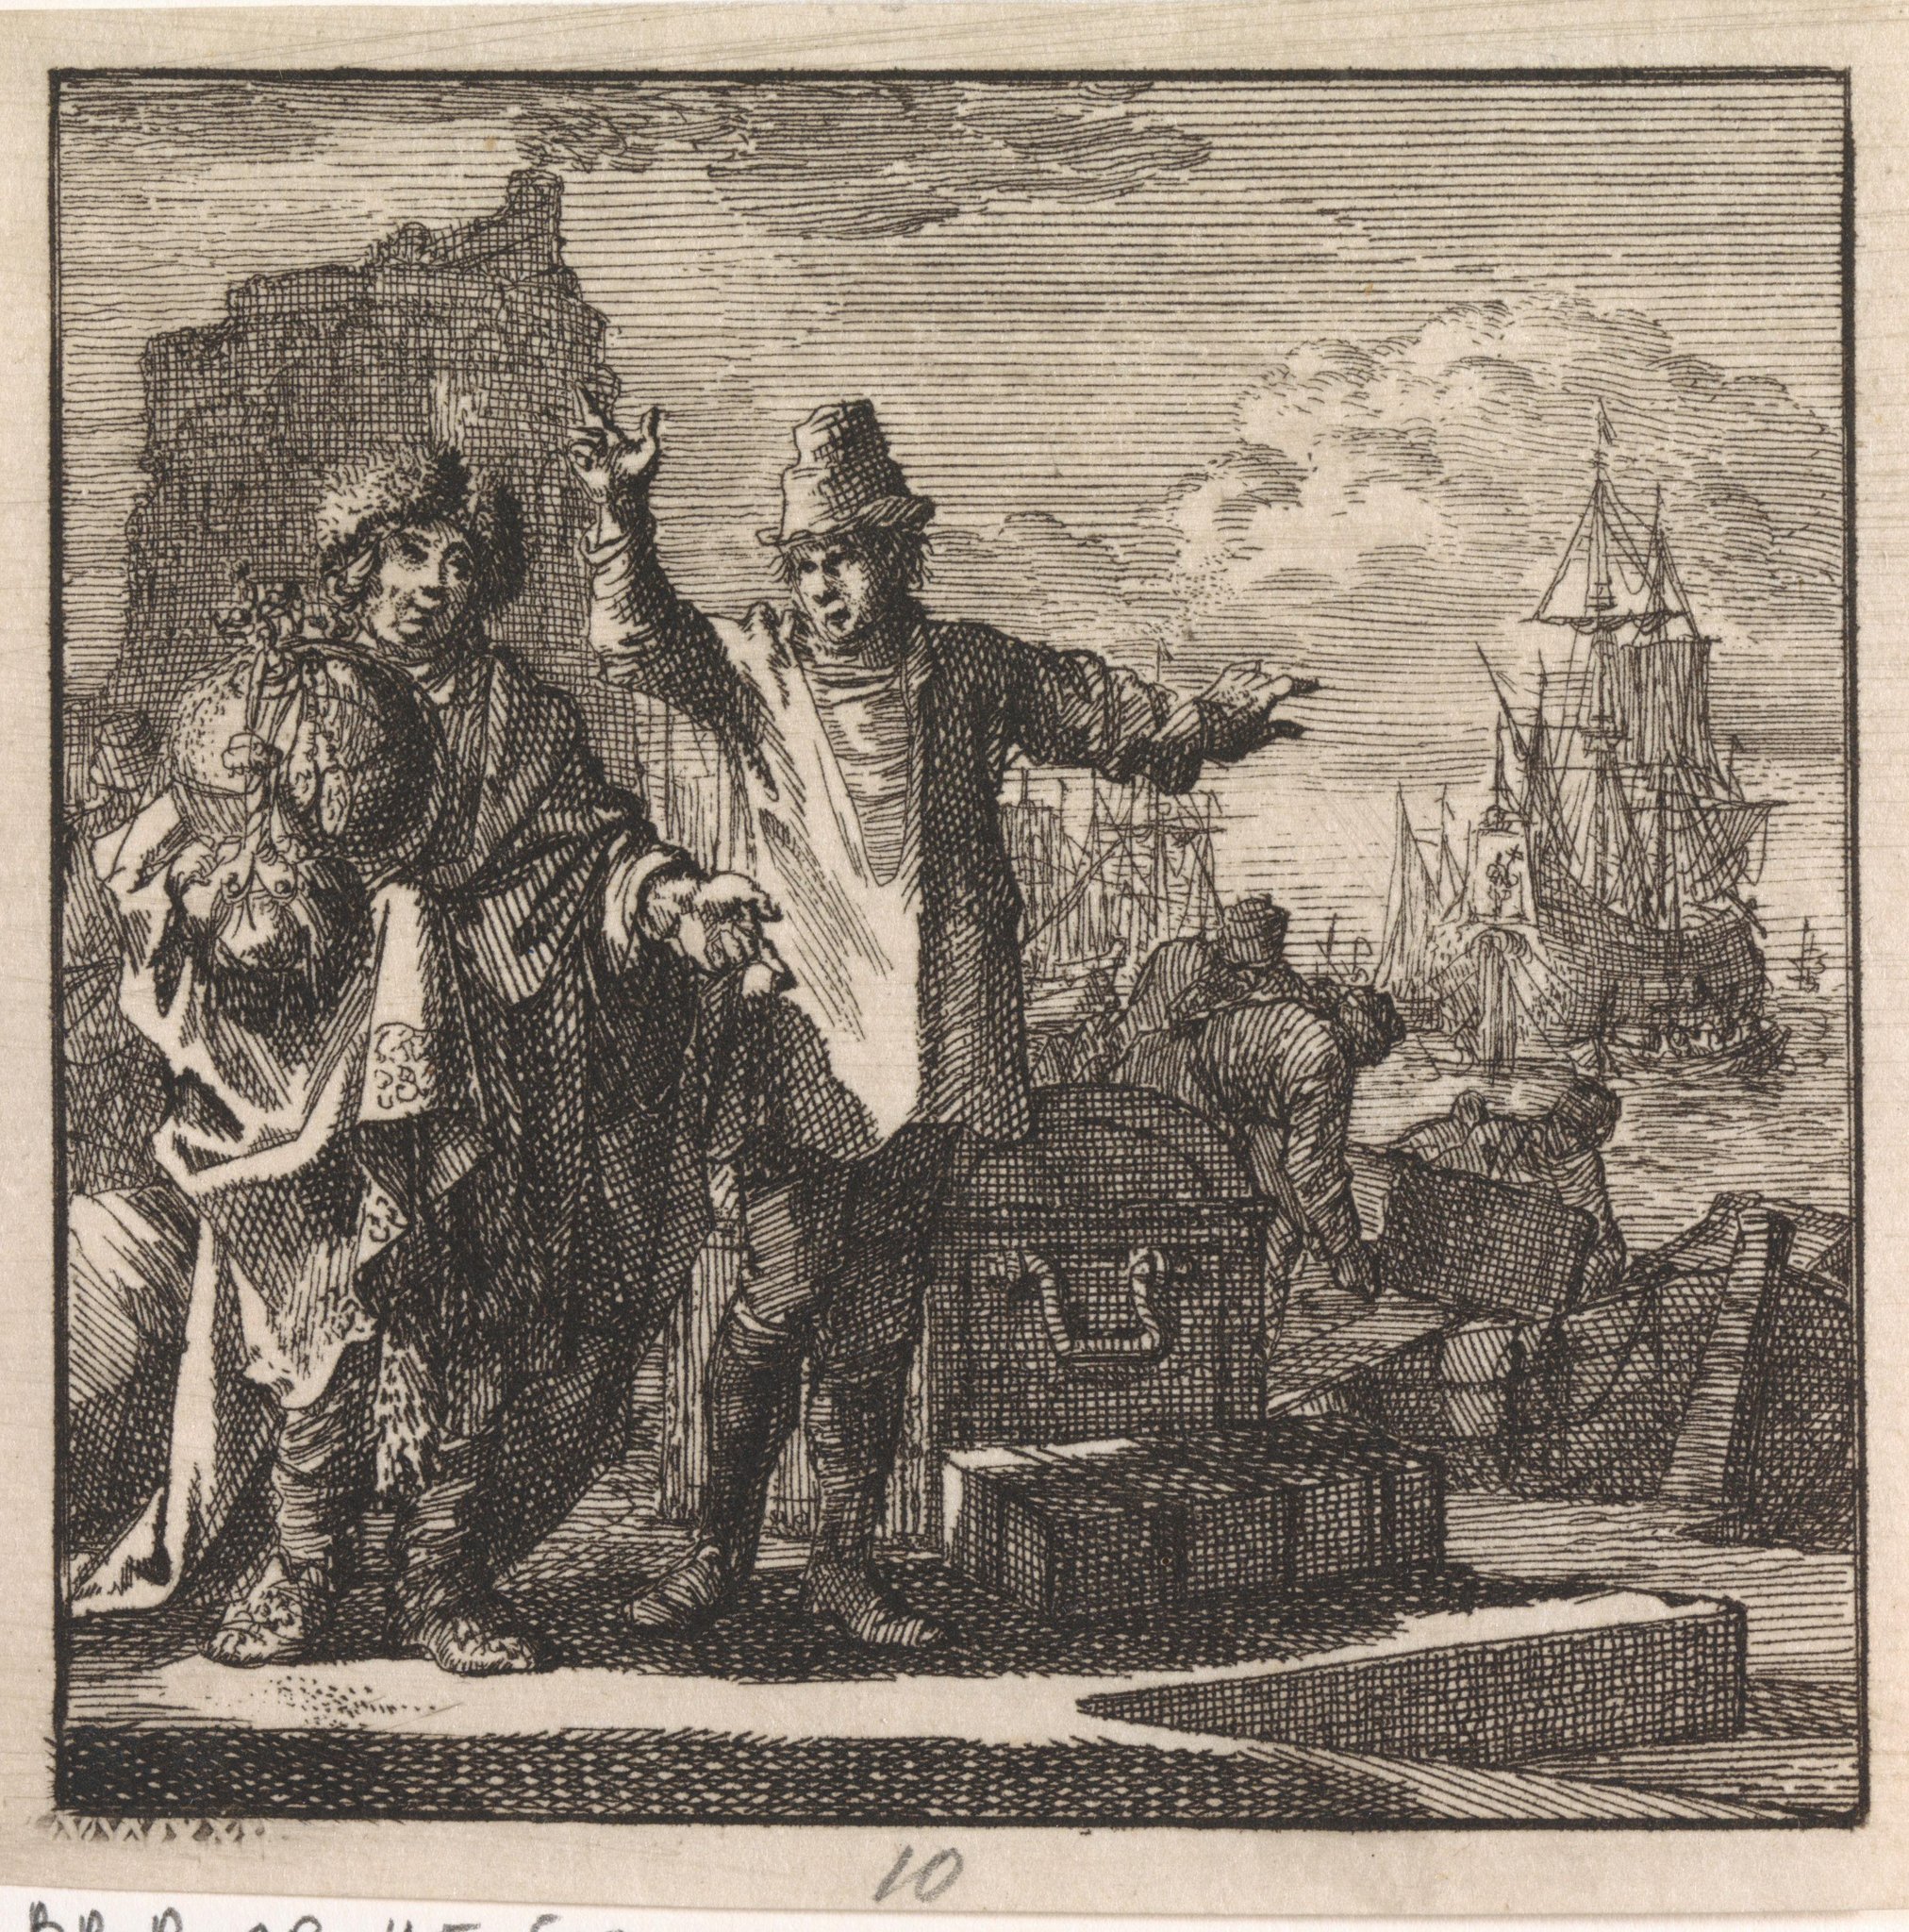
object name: print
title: De Welbedachtzaamheid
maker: jan luyken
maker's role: draughtsman, print maker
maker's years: 1649-1712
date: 1710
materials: paper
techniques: etching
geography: amsterdam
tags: harbour, conversation, dialogue; conversation piece, globe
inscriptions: collector's mark: Lugt 2228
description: Proefdruk voor illustratie uit: Luyken, Jan. De onwaardige wereld, vertoond in vyftig zinnebeelden, met godlyke spreuken en stichtelyke verzen. Amsterdam: Pieter Arentsz. II (wed.) en Cornelis van der Sys, 1710, p. 38.